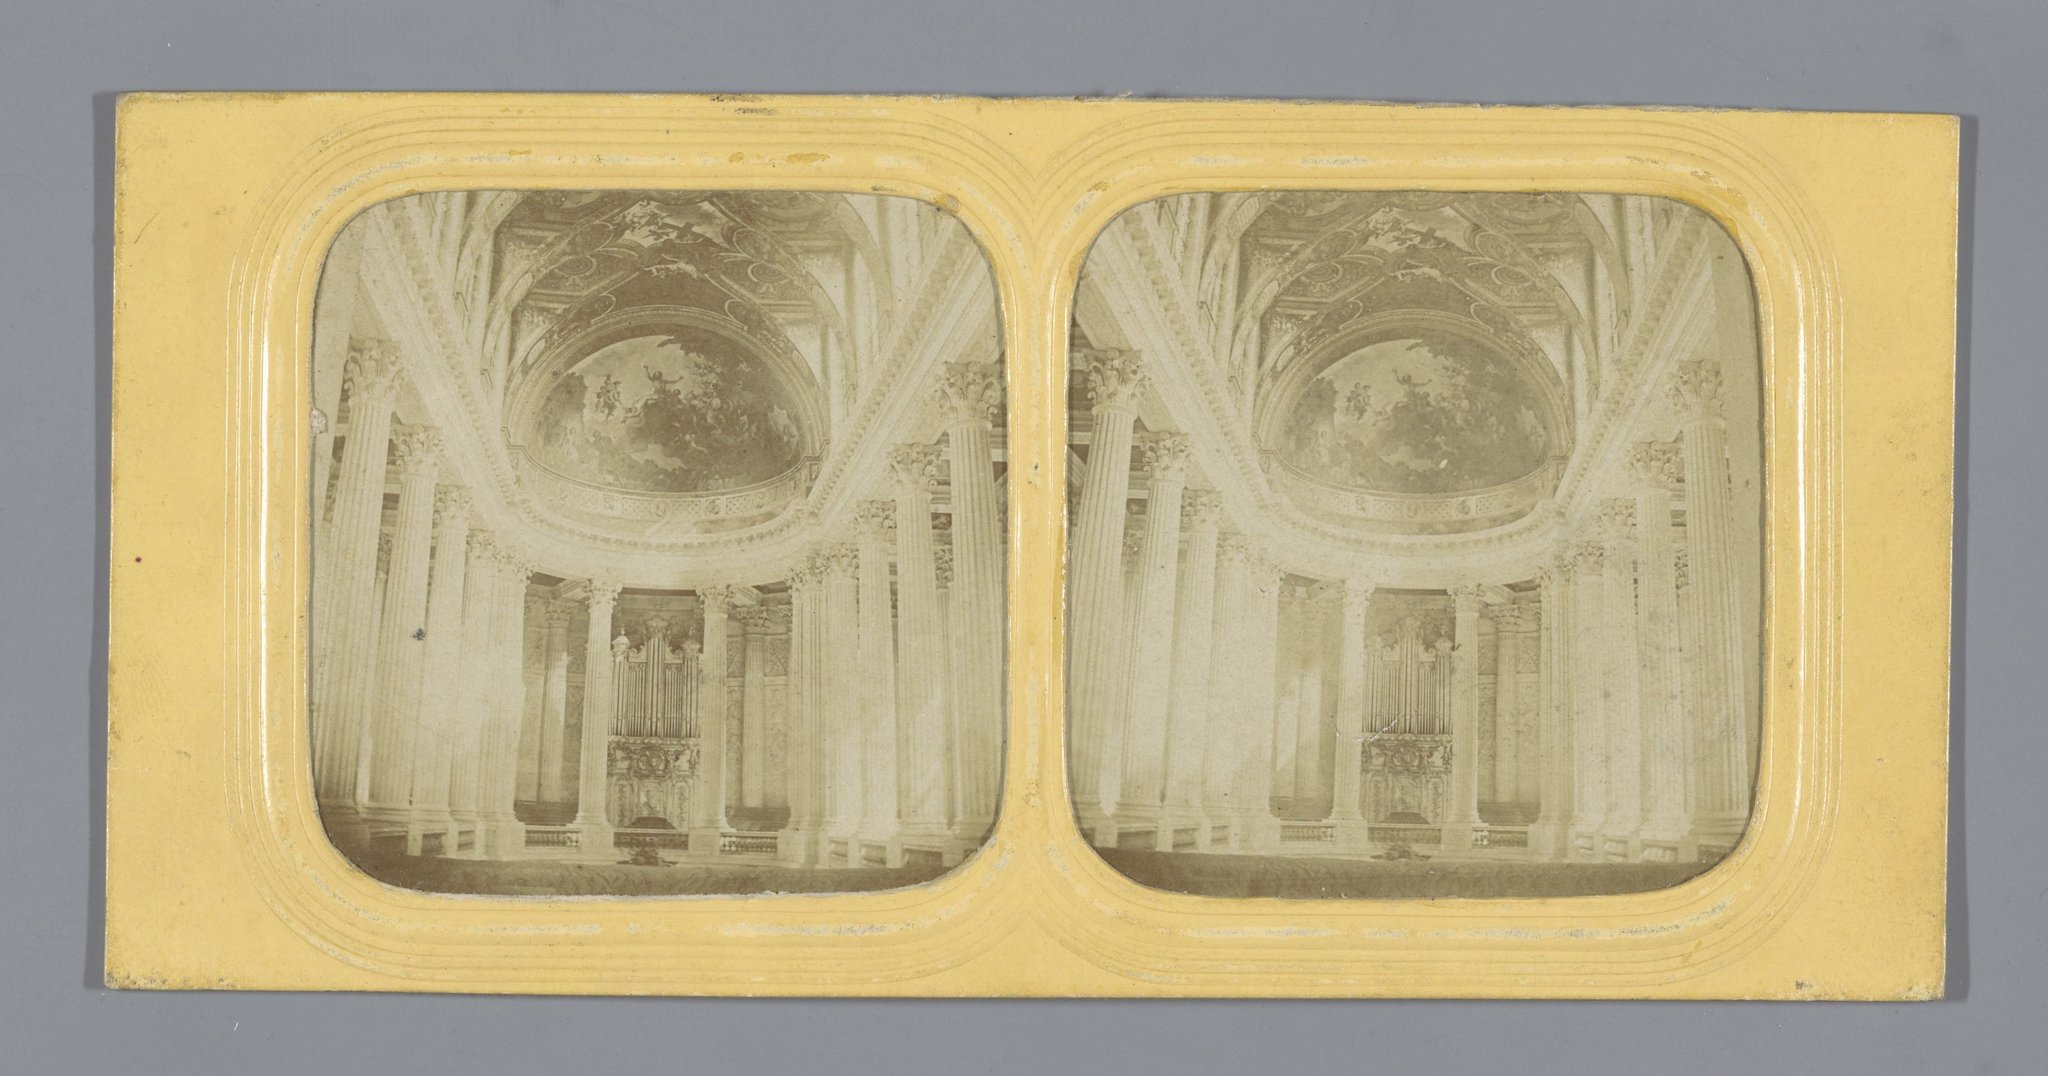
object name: tissue stereograph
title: Interieur van de kapel bij het paleis van Versailles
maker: Anonymous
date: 1855-1875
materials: cardboard, paper, photographic support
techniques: albumen print, hand coloring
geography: versailles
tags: parts of church exterior and annexes: chapel